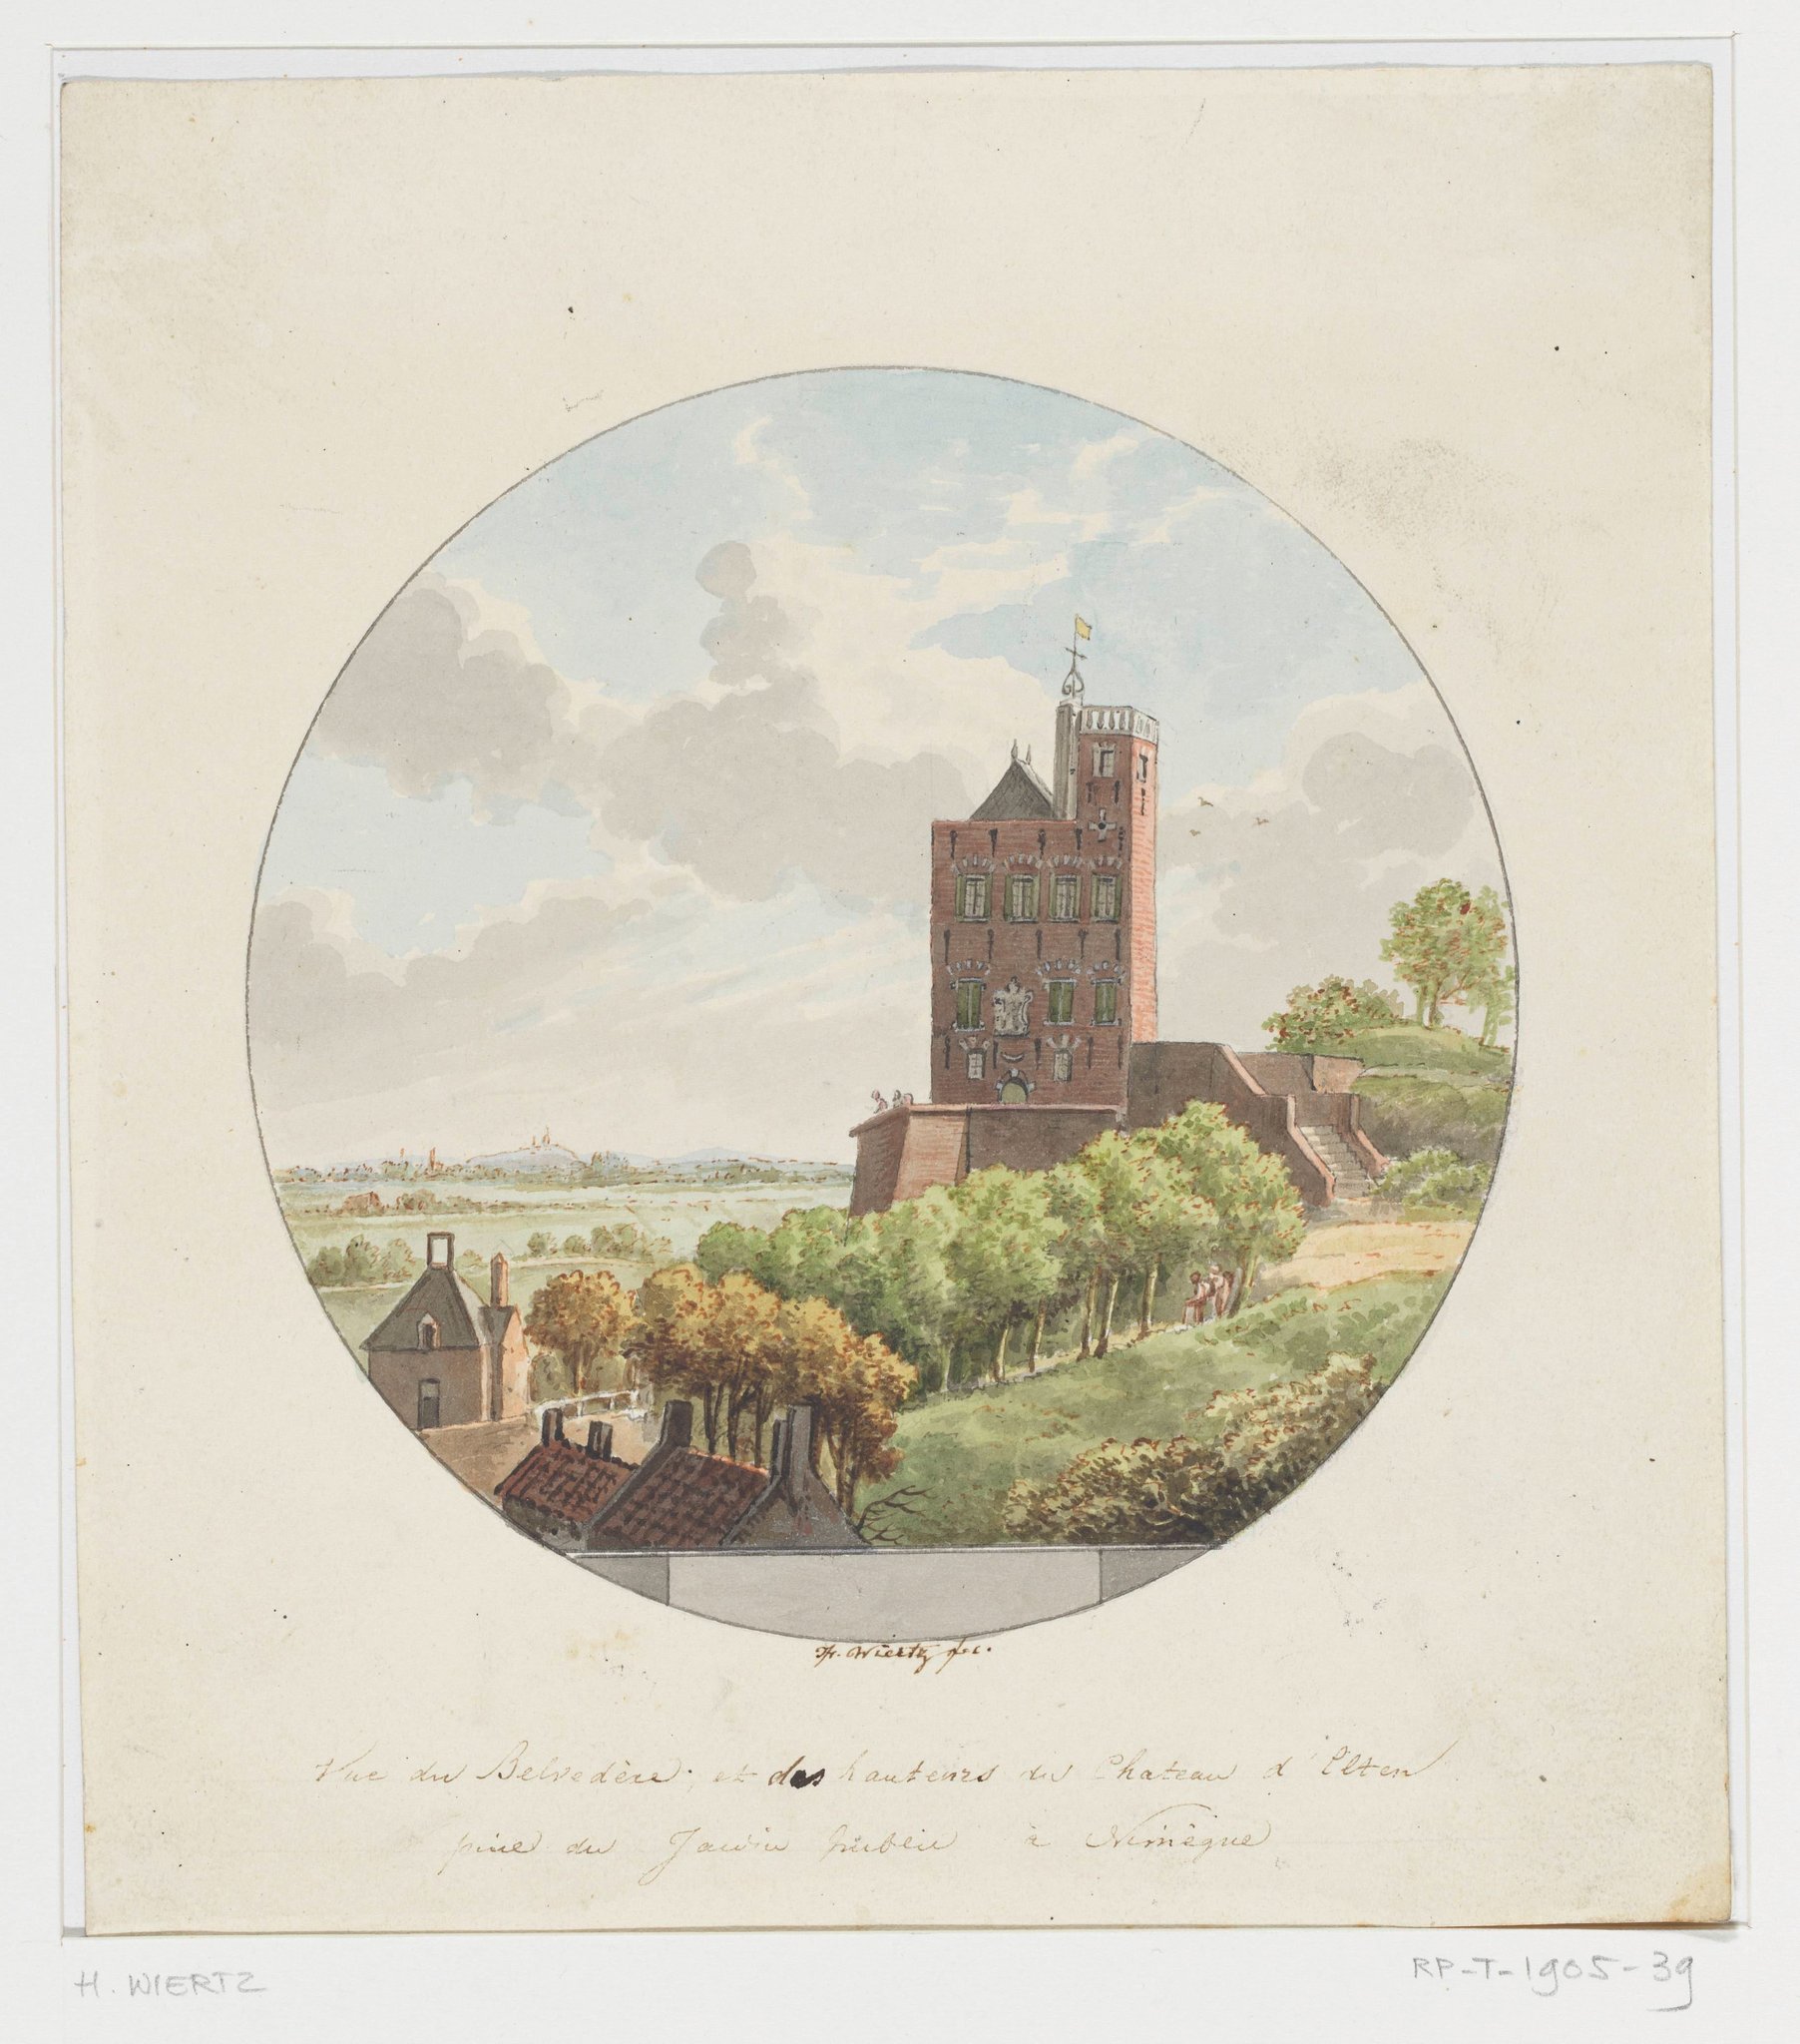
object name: watercolor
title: Belvédère te Nijmegen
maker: henricus franciscus wiertz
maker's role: draughtsman, painter, print maker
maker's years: 1784-1858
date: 1794-1858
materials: ink, paper, pencil, watercolor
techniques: brush, pen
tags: low hill country, castle, nijmegen